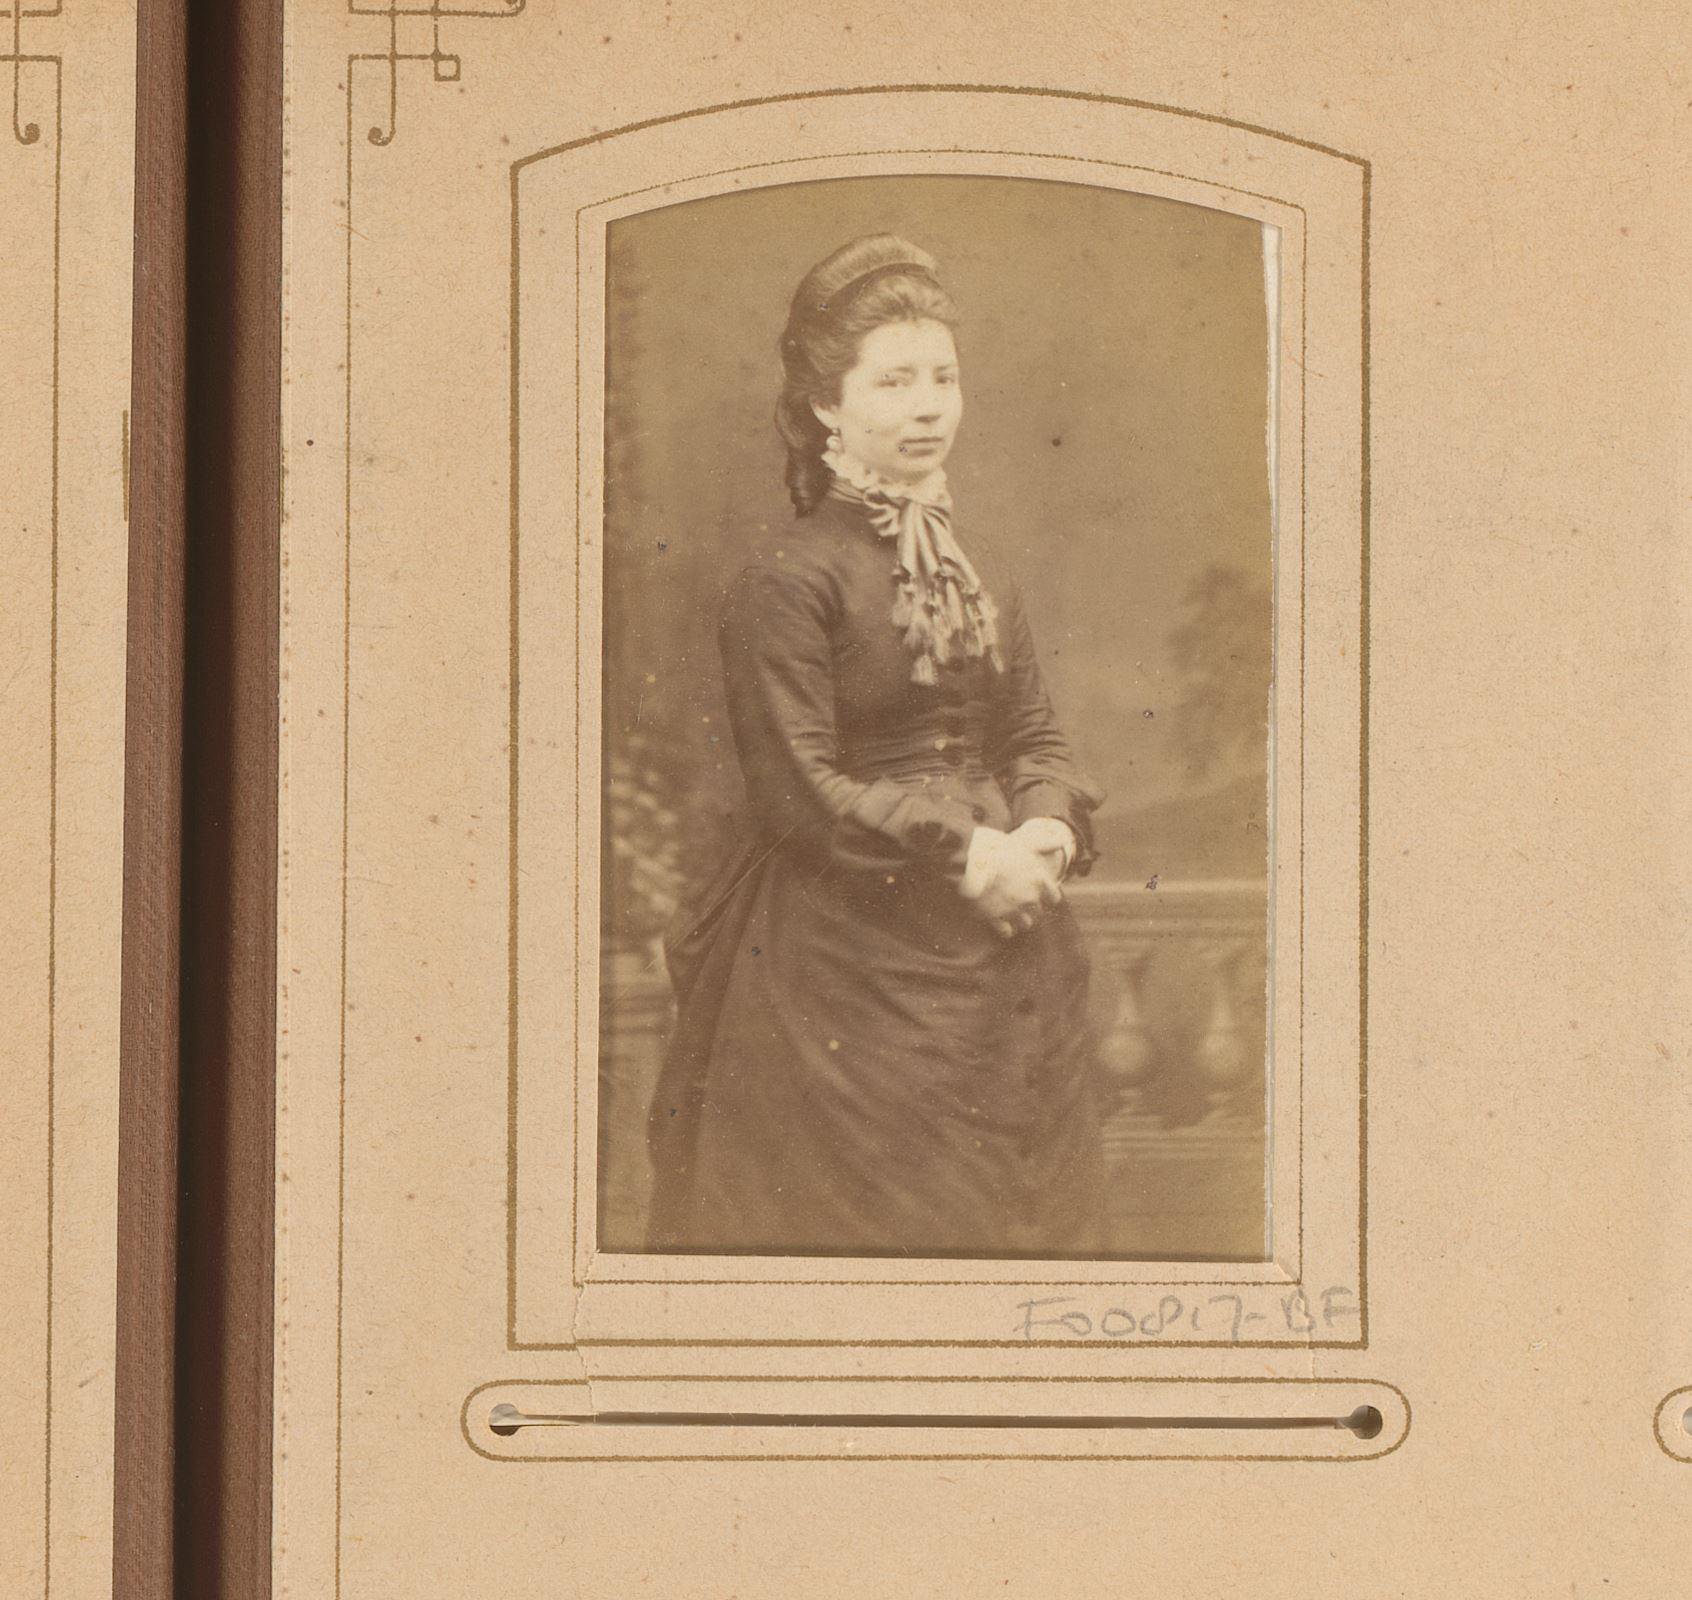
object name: carte de visite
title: Portret van een staande vrouw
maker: Anonymous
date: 1860-1900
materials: cardboard, photographic support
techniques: albumen print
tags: historical persons - bb - woman